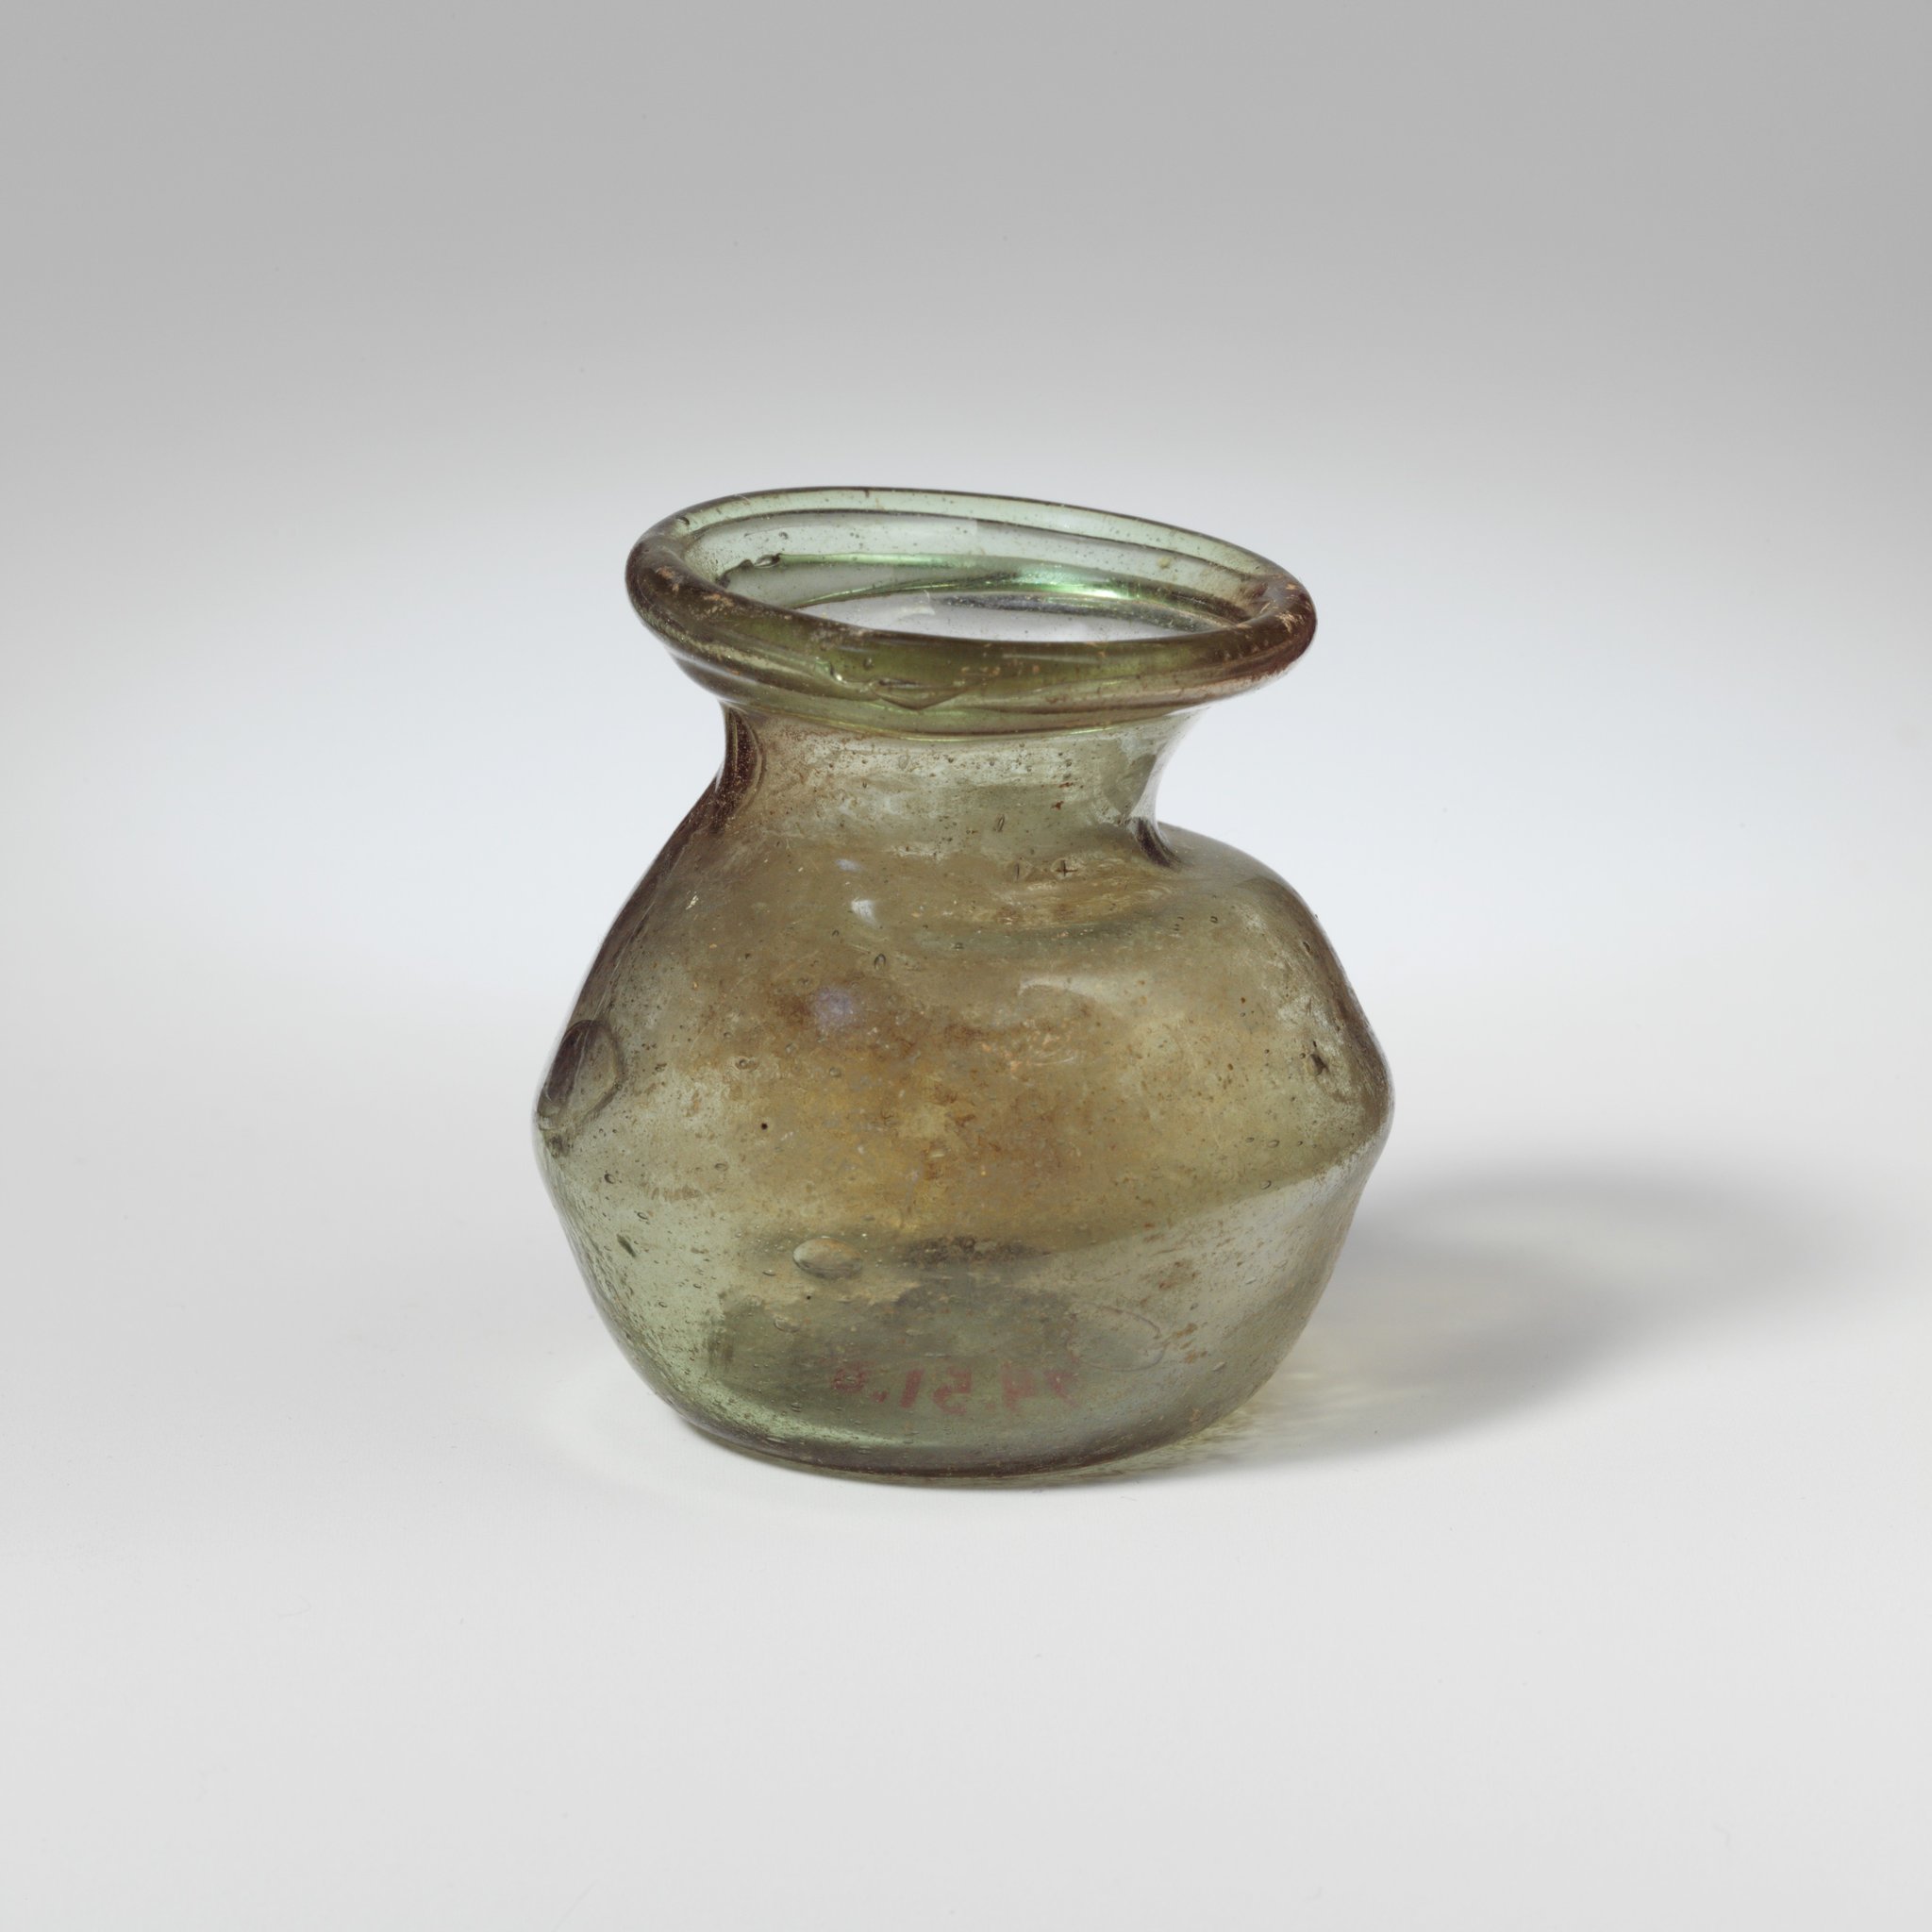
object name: jar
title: Glass miniature jar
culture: roman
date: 101-300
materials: glass